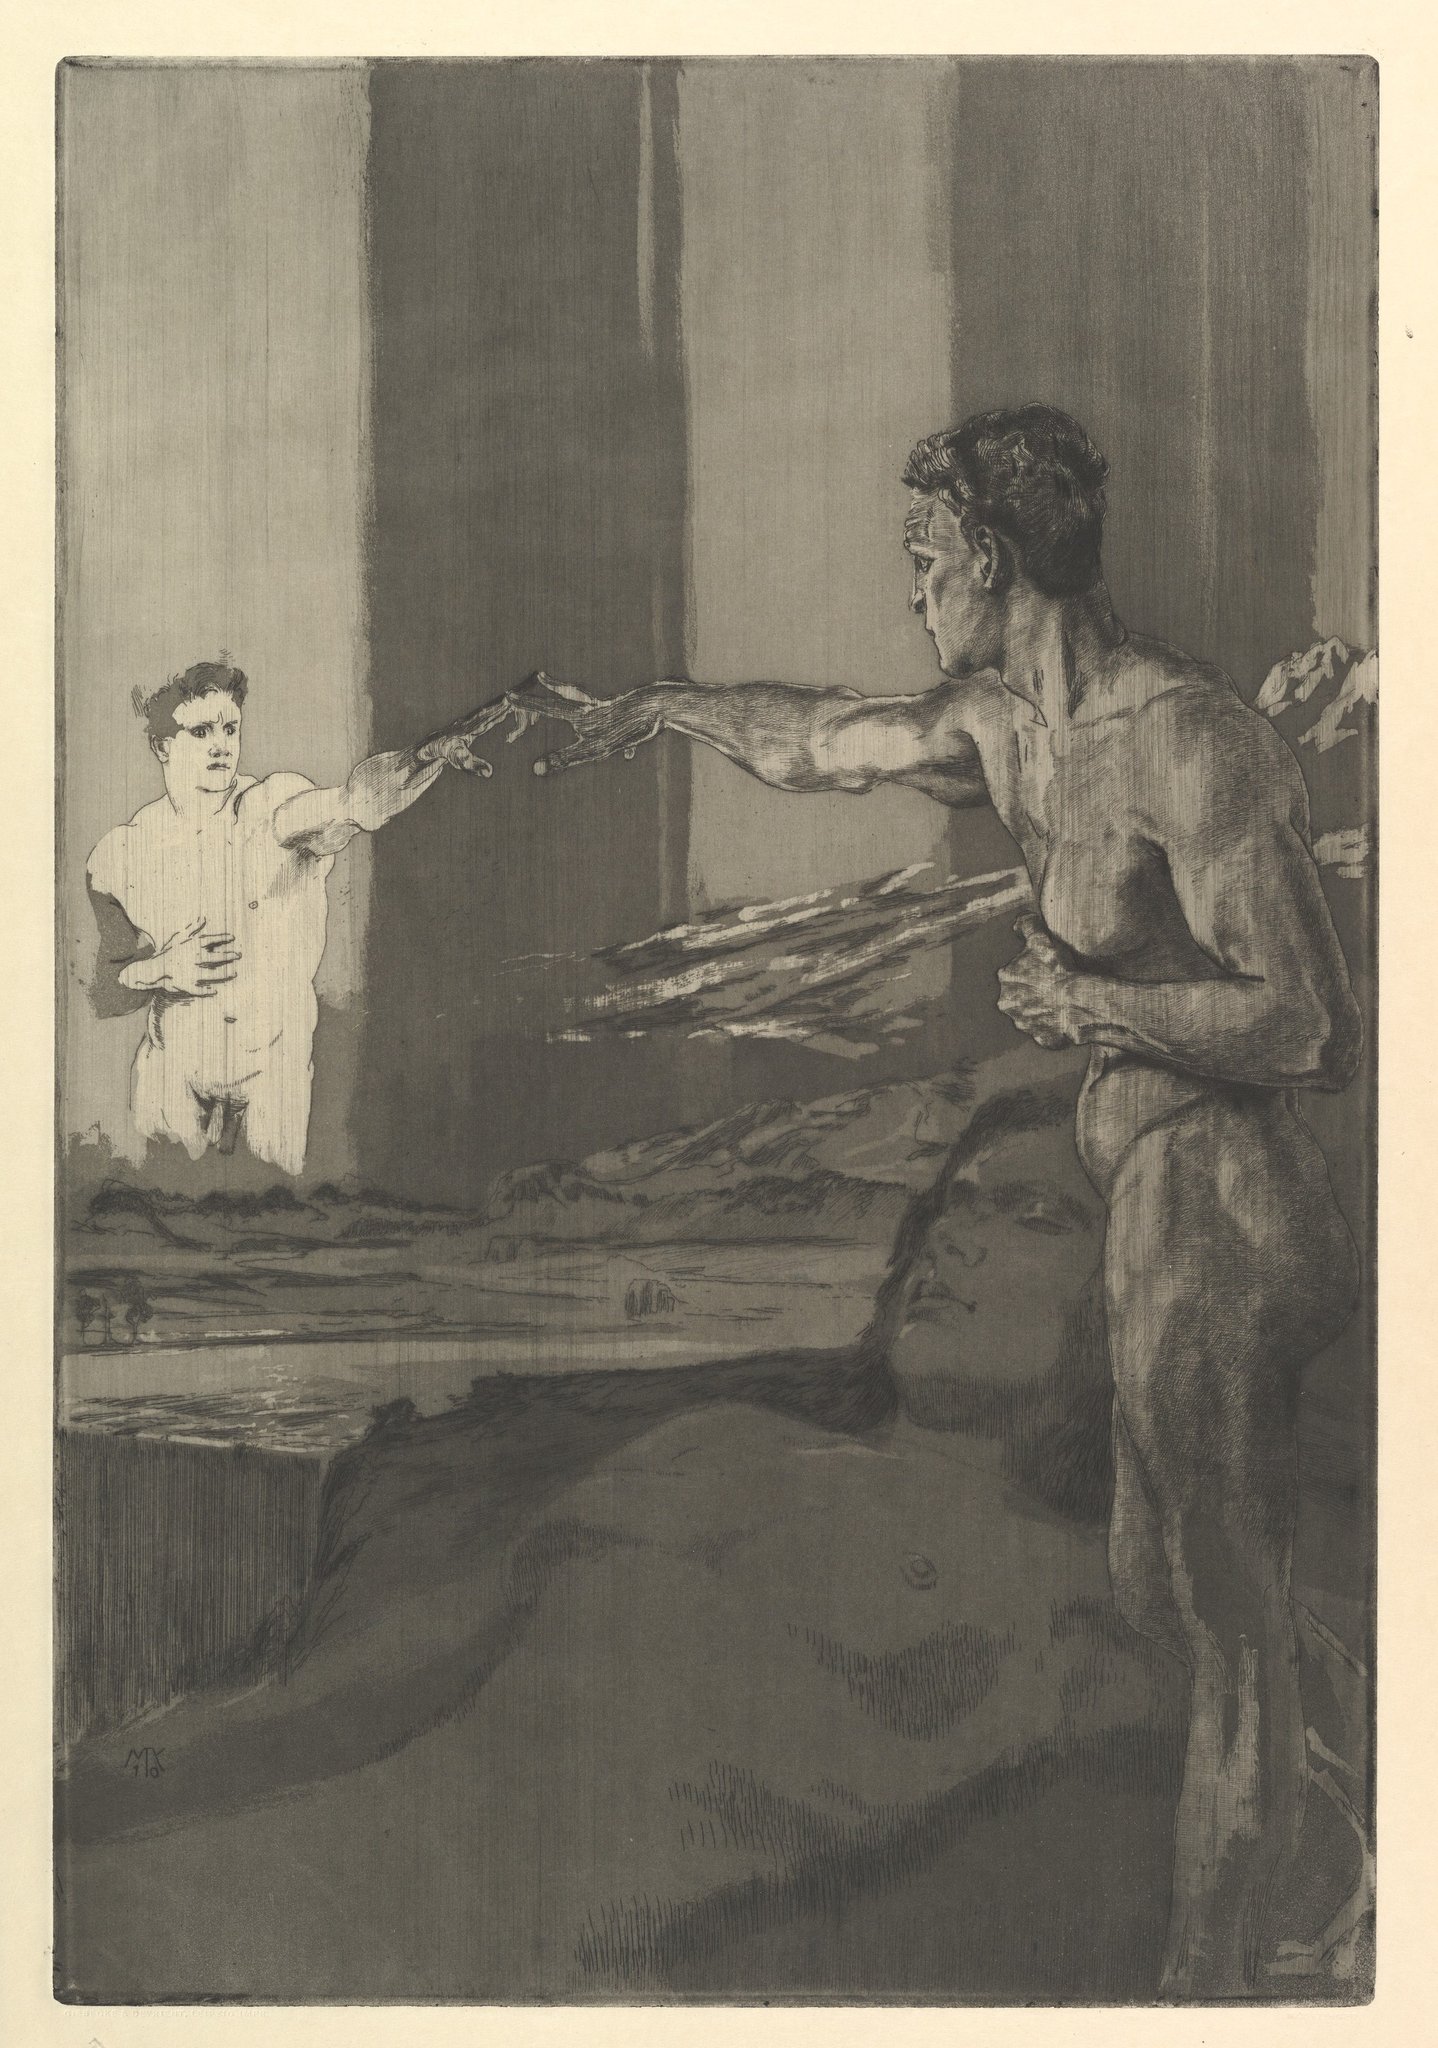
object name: print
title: Philosopher (from the series On Death II)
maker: max klinger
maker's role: artist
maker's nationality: german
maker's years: 1857-1920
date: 1898-1910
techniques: aquatint, etching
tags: male nudes